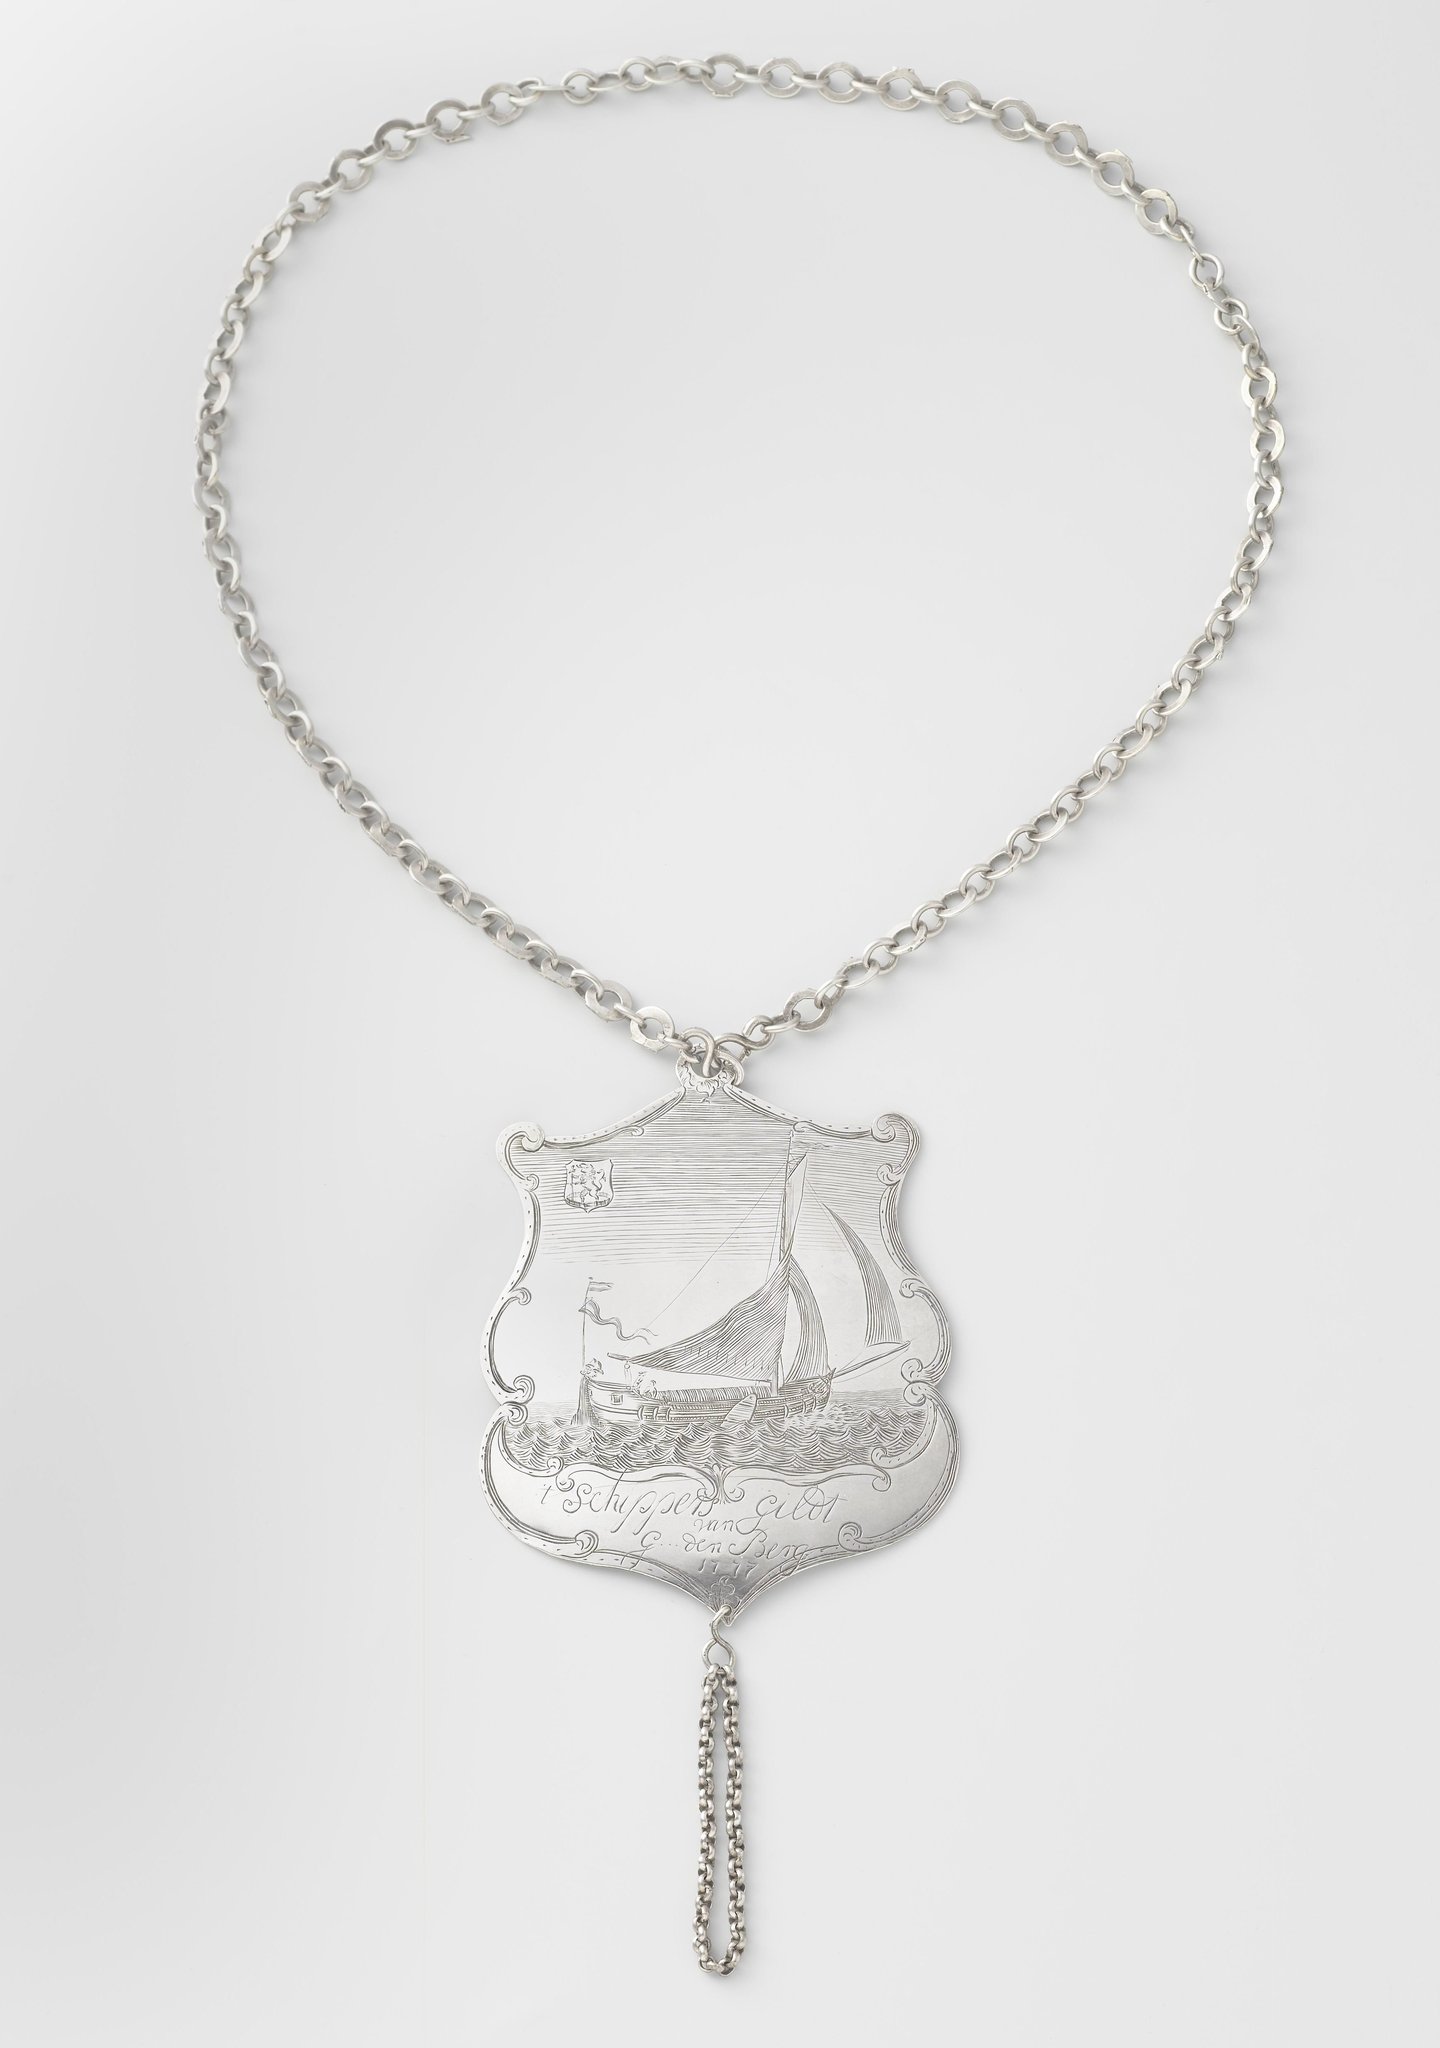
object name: shield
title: Gildenschild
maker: Anonymous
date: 1777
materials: silver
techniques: engraving, forging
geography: netherlands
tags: j. van de berg (schipper)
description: Een zilveren gildenschild in de vorm van een wapen, met de afbeelding van een zeilschip op het water met gehesen zeilen, zijzwaard, gaffeltuig, een roerkop in de vorm van een mannekop en op het achtersteven vlag en wimpel. Aan de onderzijde het opschrift: 't Schippersgildt van G. den Berg 1777. Linksboven het wapen van Holland. Middenboven aan het schild een lange ketting aan een oog. Middenonder is een kleine ketting aan het schild bevestigd. Gemerkt achterkant midden en onder: 3 zilvermerken.